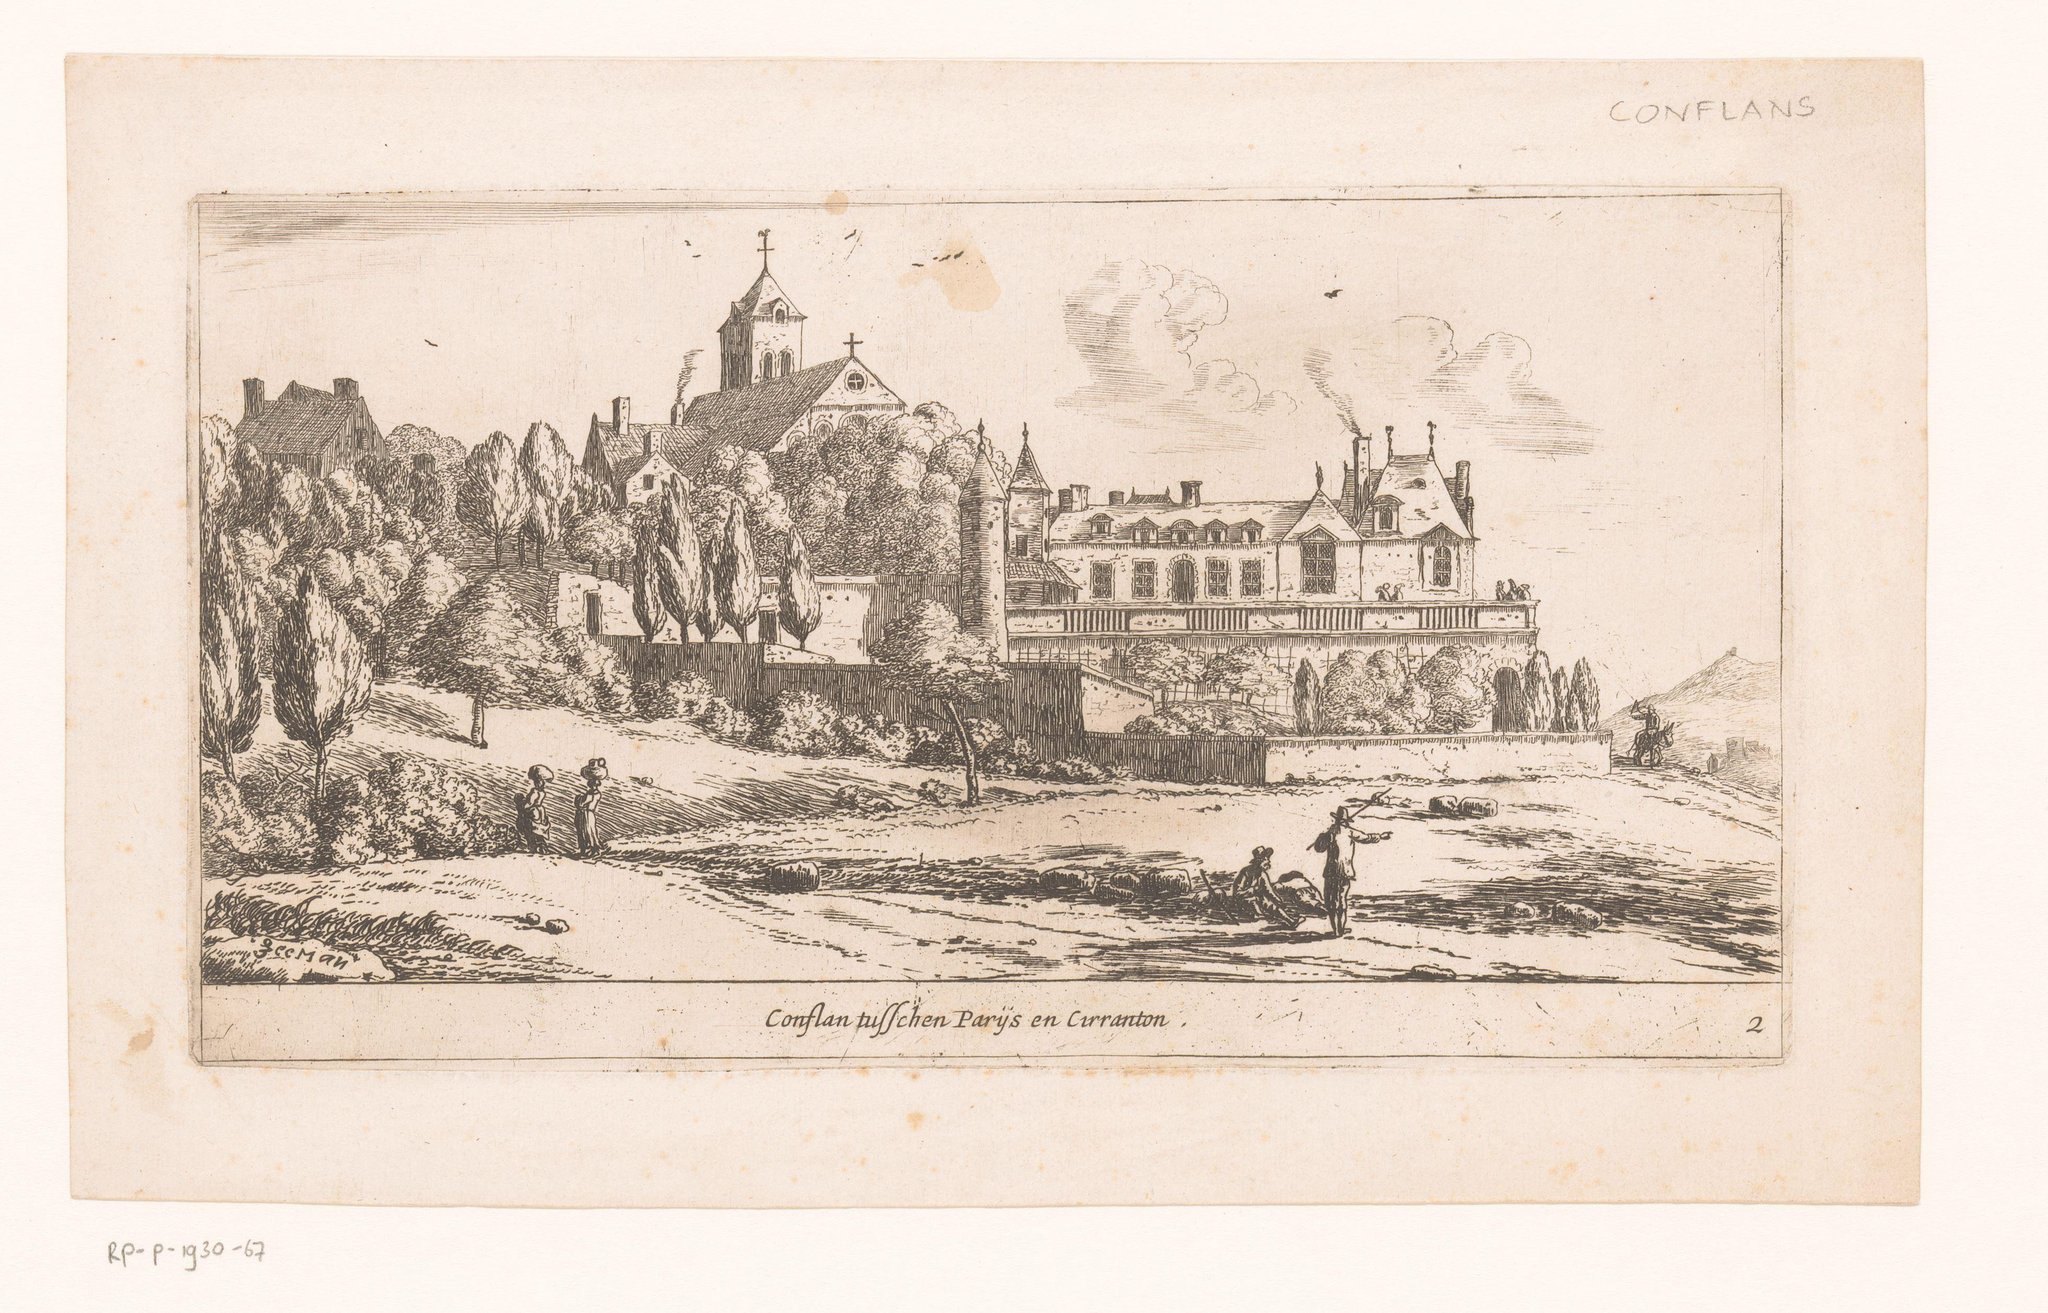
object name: print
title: Gezichten op Parijs en omgeving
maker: reinier nooms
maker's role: draughtsman, painter, print maker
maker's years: 1623-1664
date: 1656-1662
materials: paper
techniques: etching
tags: city-view in general; 'veduta'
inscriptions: collector's mark: Lugt 2228, collector's mark: Lugt 2233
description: Gezicht op Conflans, een ommuurd dorp met een kerk in een landschap. Twee herders met een kudde schapen en twee vrouwen met manden wandelen.